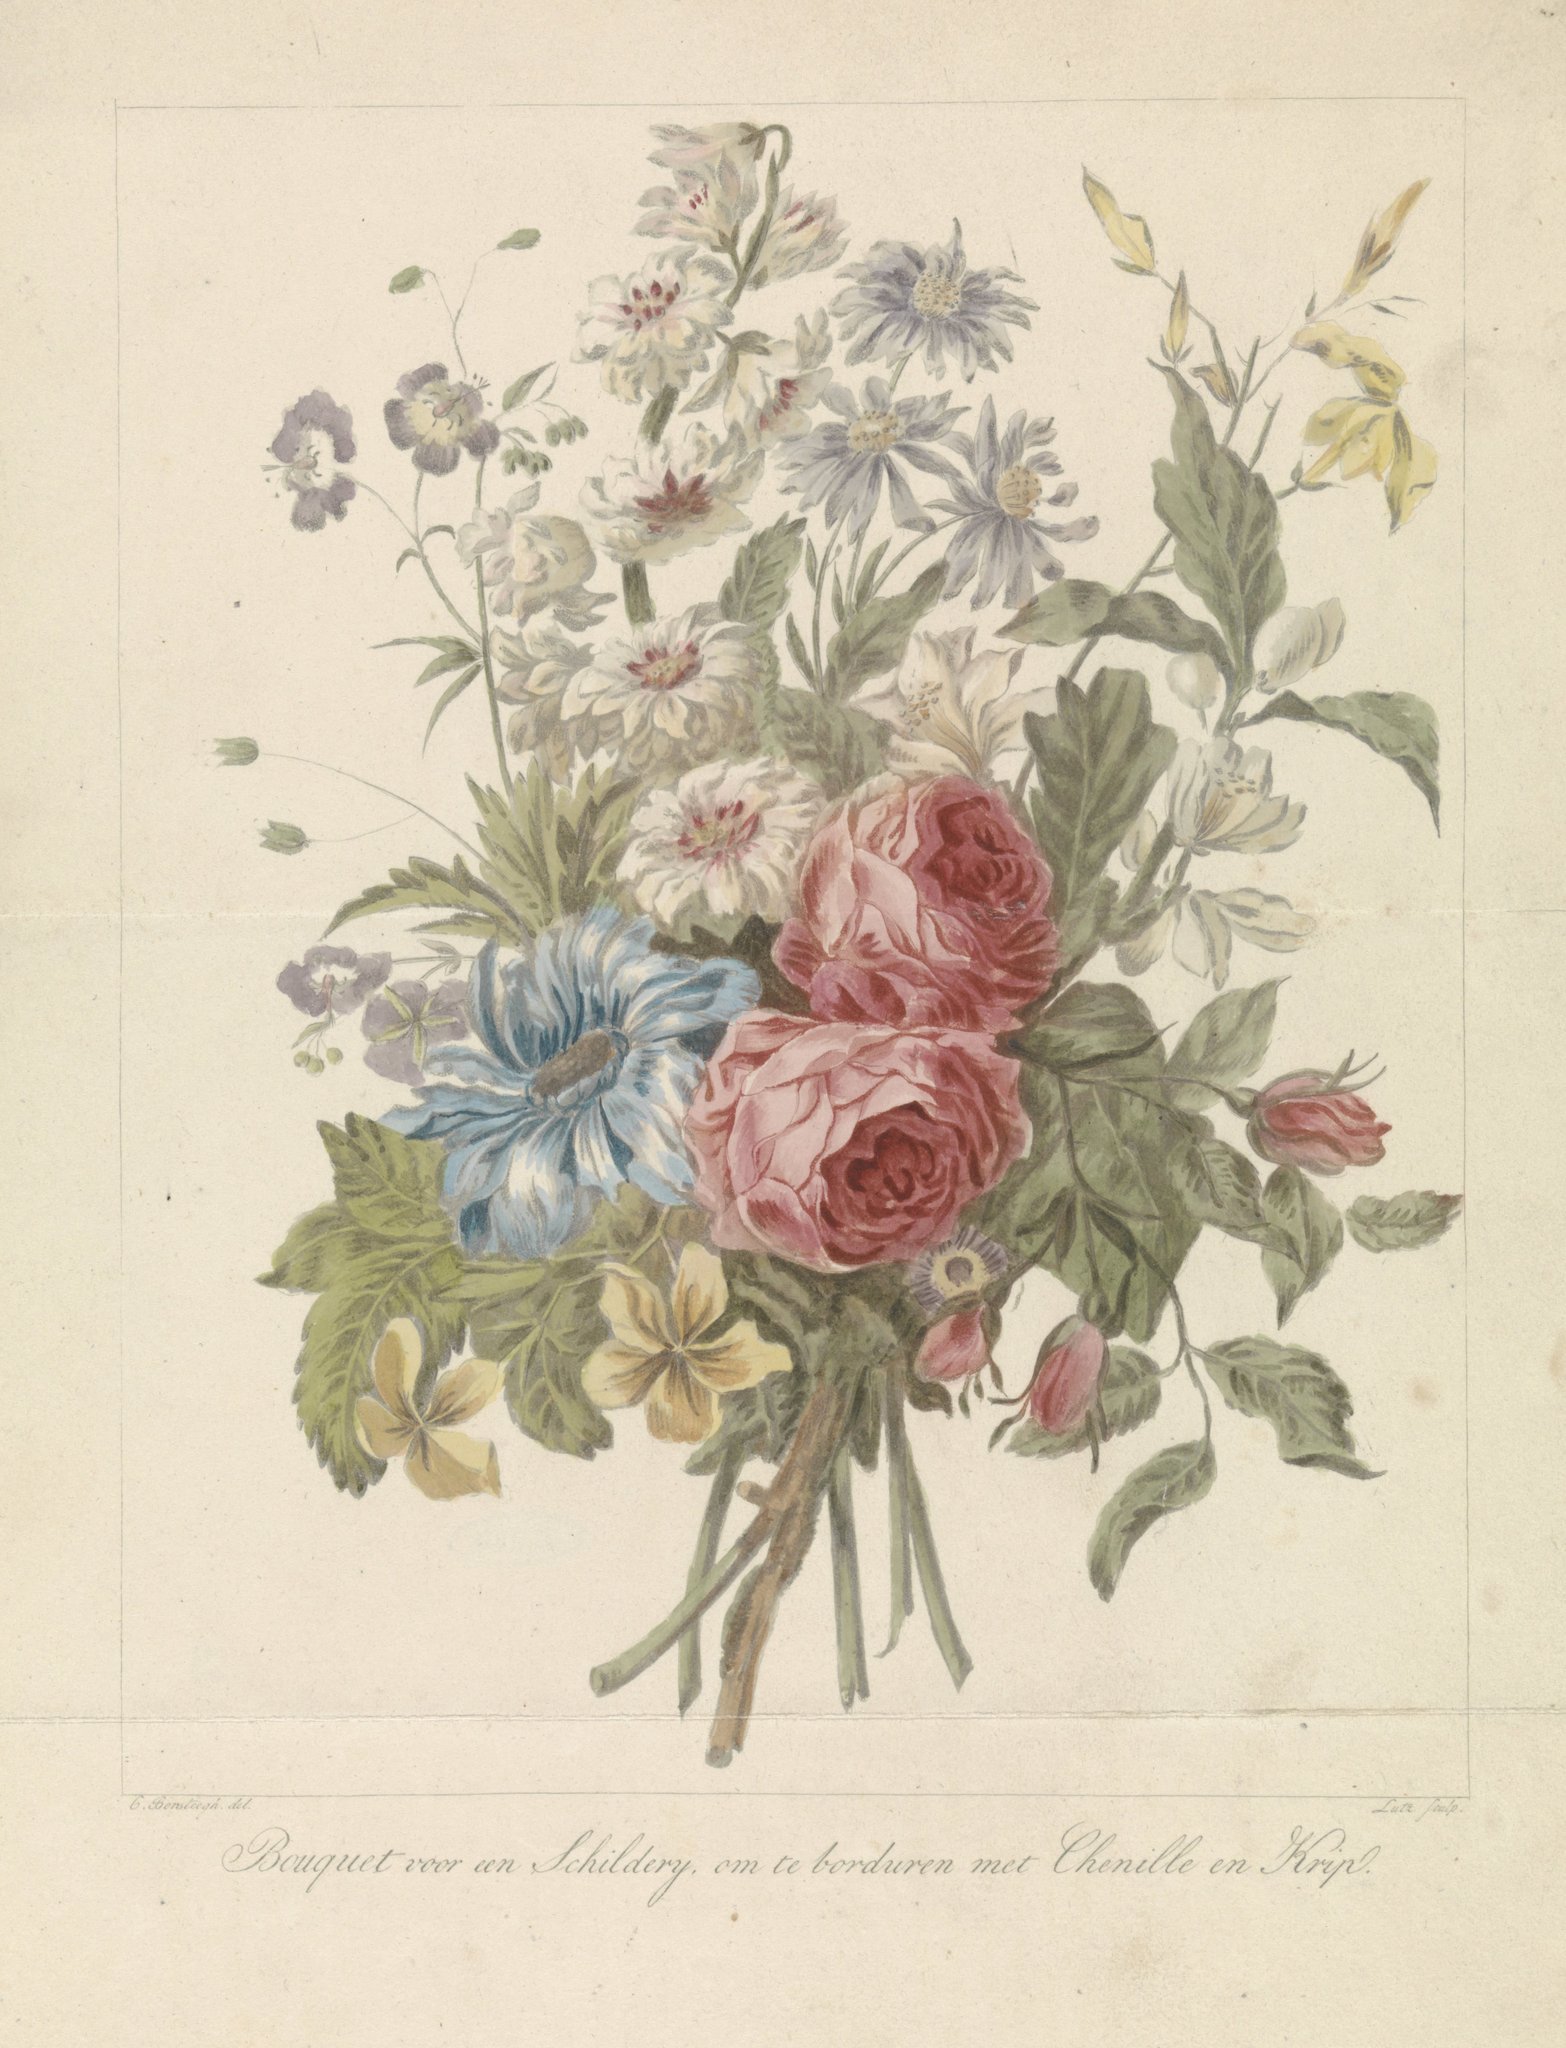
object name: print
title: Bouquet, Model for Embroidery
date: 1809-1822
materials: paper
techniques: aquatint, brush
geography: the hague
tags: flowers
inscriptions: collector's mark: Lugt 2228, collector's mark: Lugt 2760